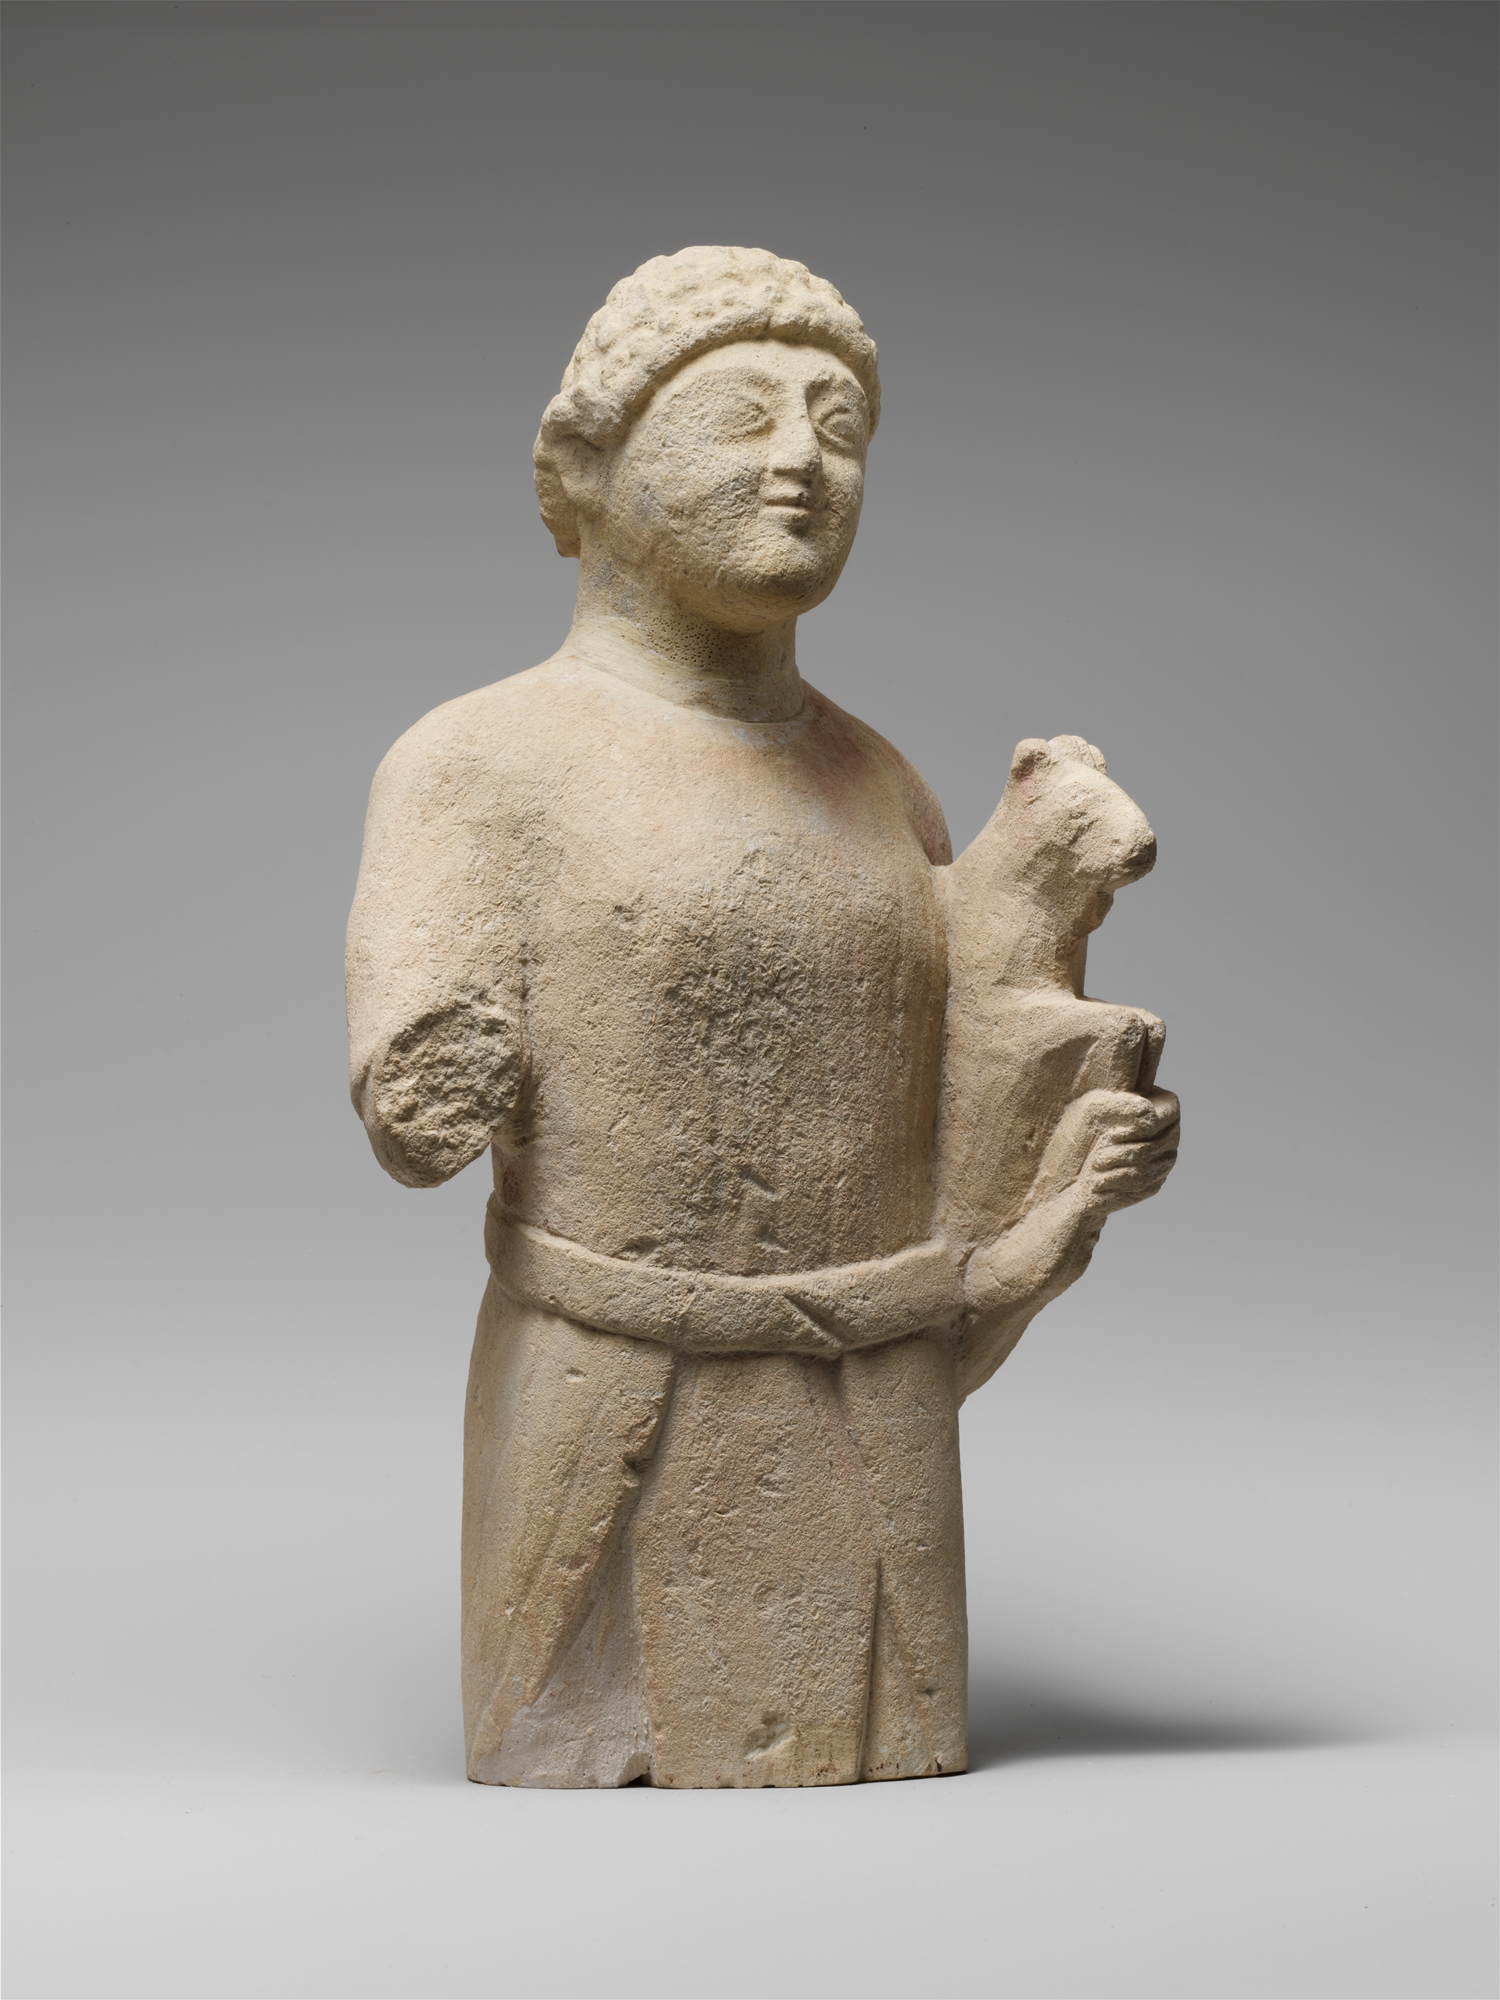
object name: statuette of a votary, male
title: Limestone statuette of a male votary (worshipper)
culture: cypriot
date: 567-535 BCE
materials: limestone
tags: men,goats